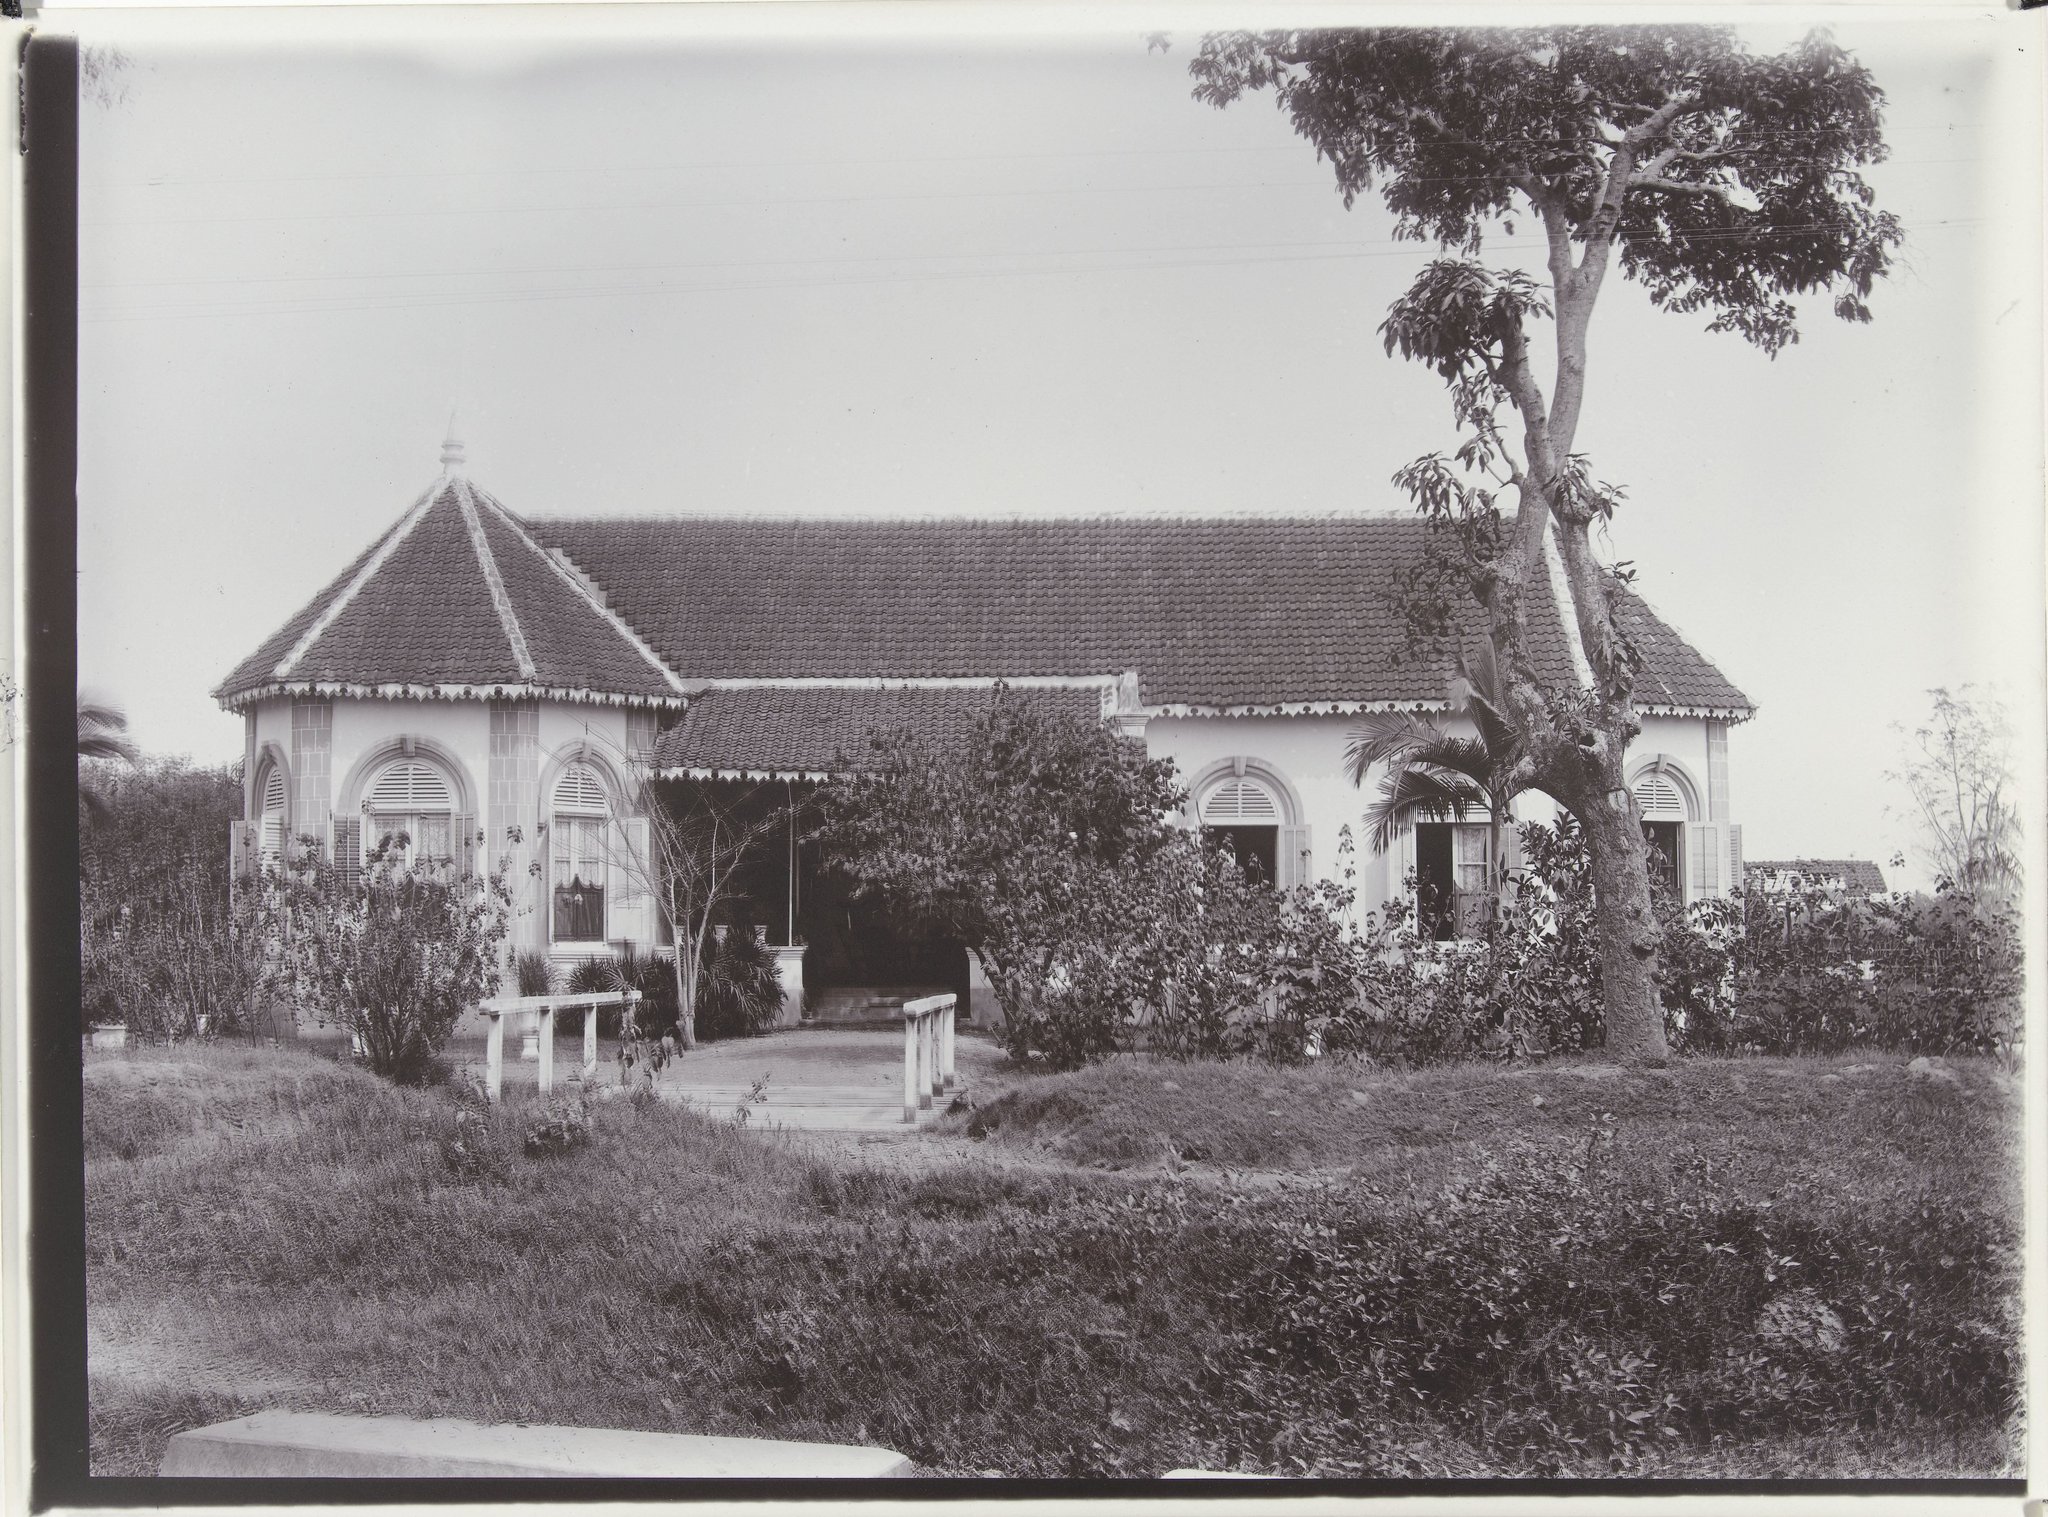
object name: photograph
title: Groot huis op de suikeronderneming Nieuw Tersana, Cheribon, voormalig Nederlands-Indië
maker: onnes kurkdjian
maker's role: fotograaf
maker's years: 1851-1903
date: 1890-1911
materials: paper, photographic support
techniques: gelatin silver print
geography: cirebon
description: Groot huis op de suikeronderneming Nieuw Tersana, Cheribon, voormalig Nederlands-Indië